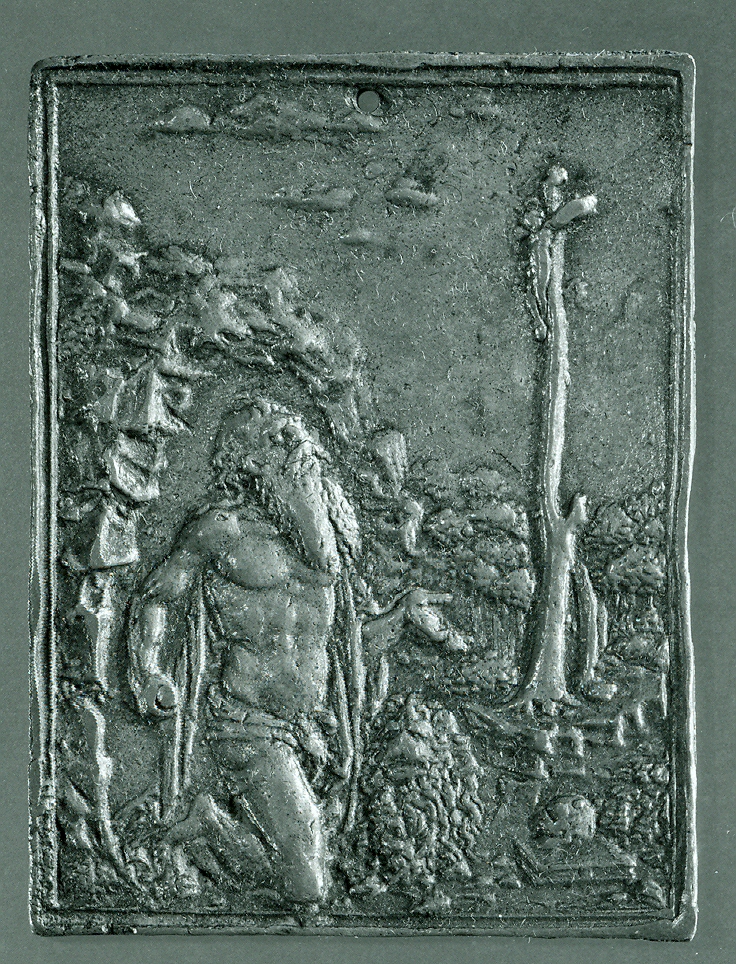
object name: plaquette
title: St. Jerome in the Wilderness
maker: moderno (galeazzo mondella)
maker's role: artist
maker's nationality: italian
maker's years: 1467-1528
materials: copper alloy, patina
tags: saint jerome,crucifixion